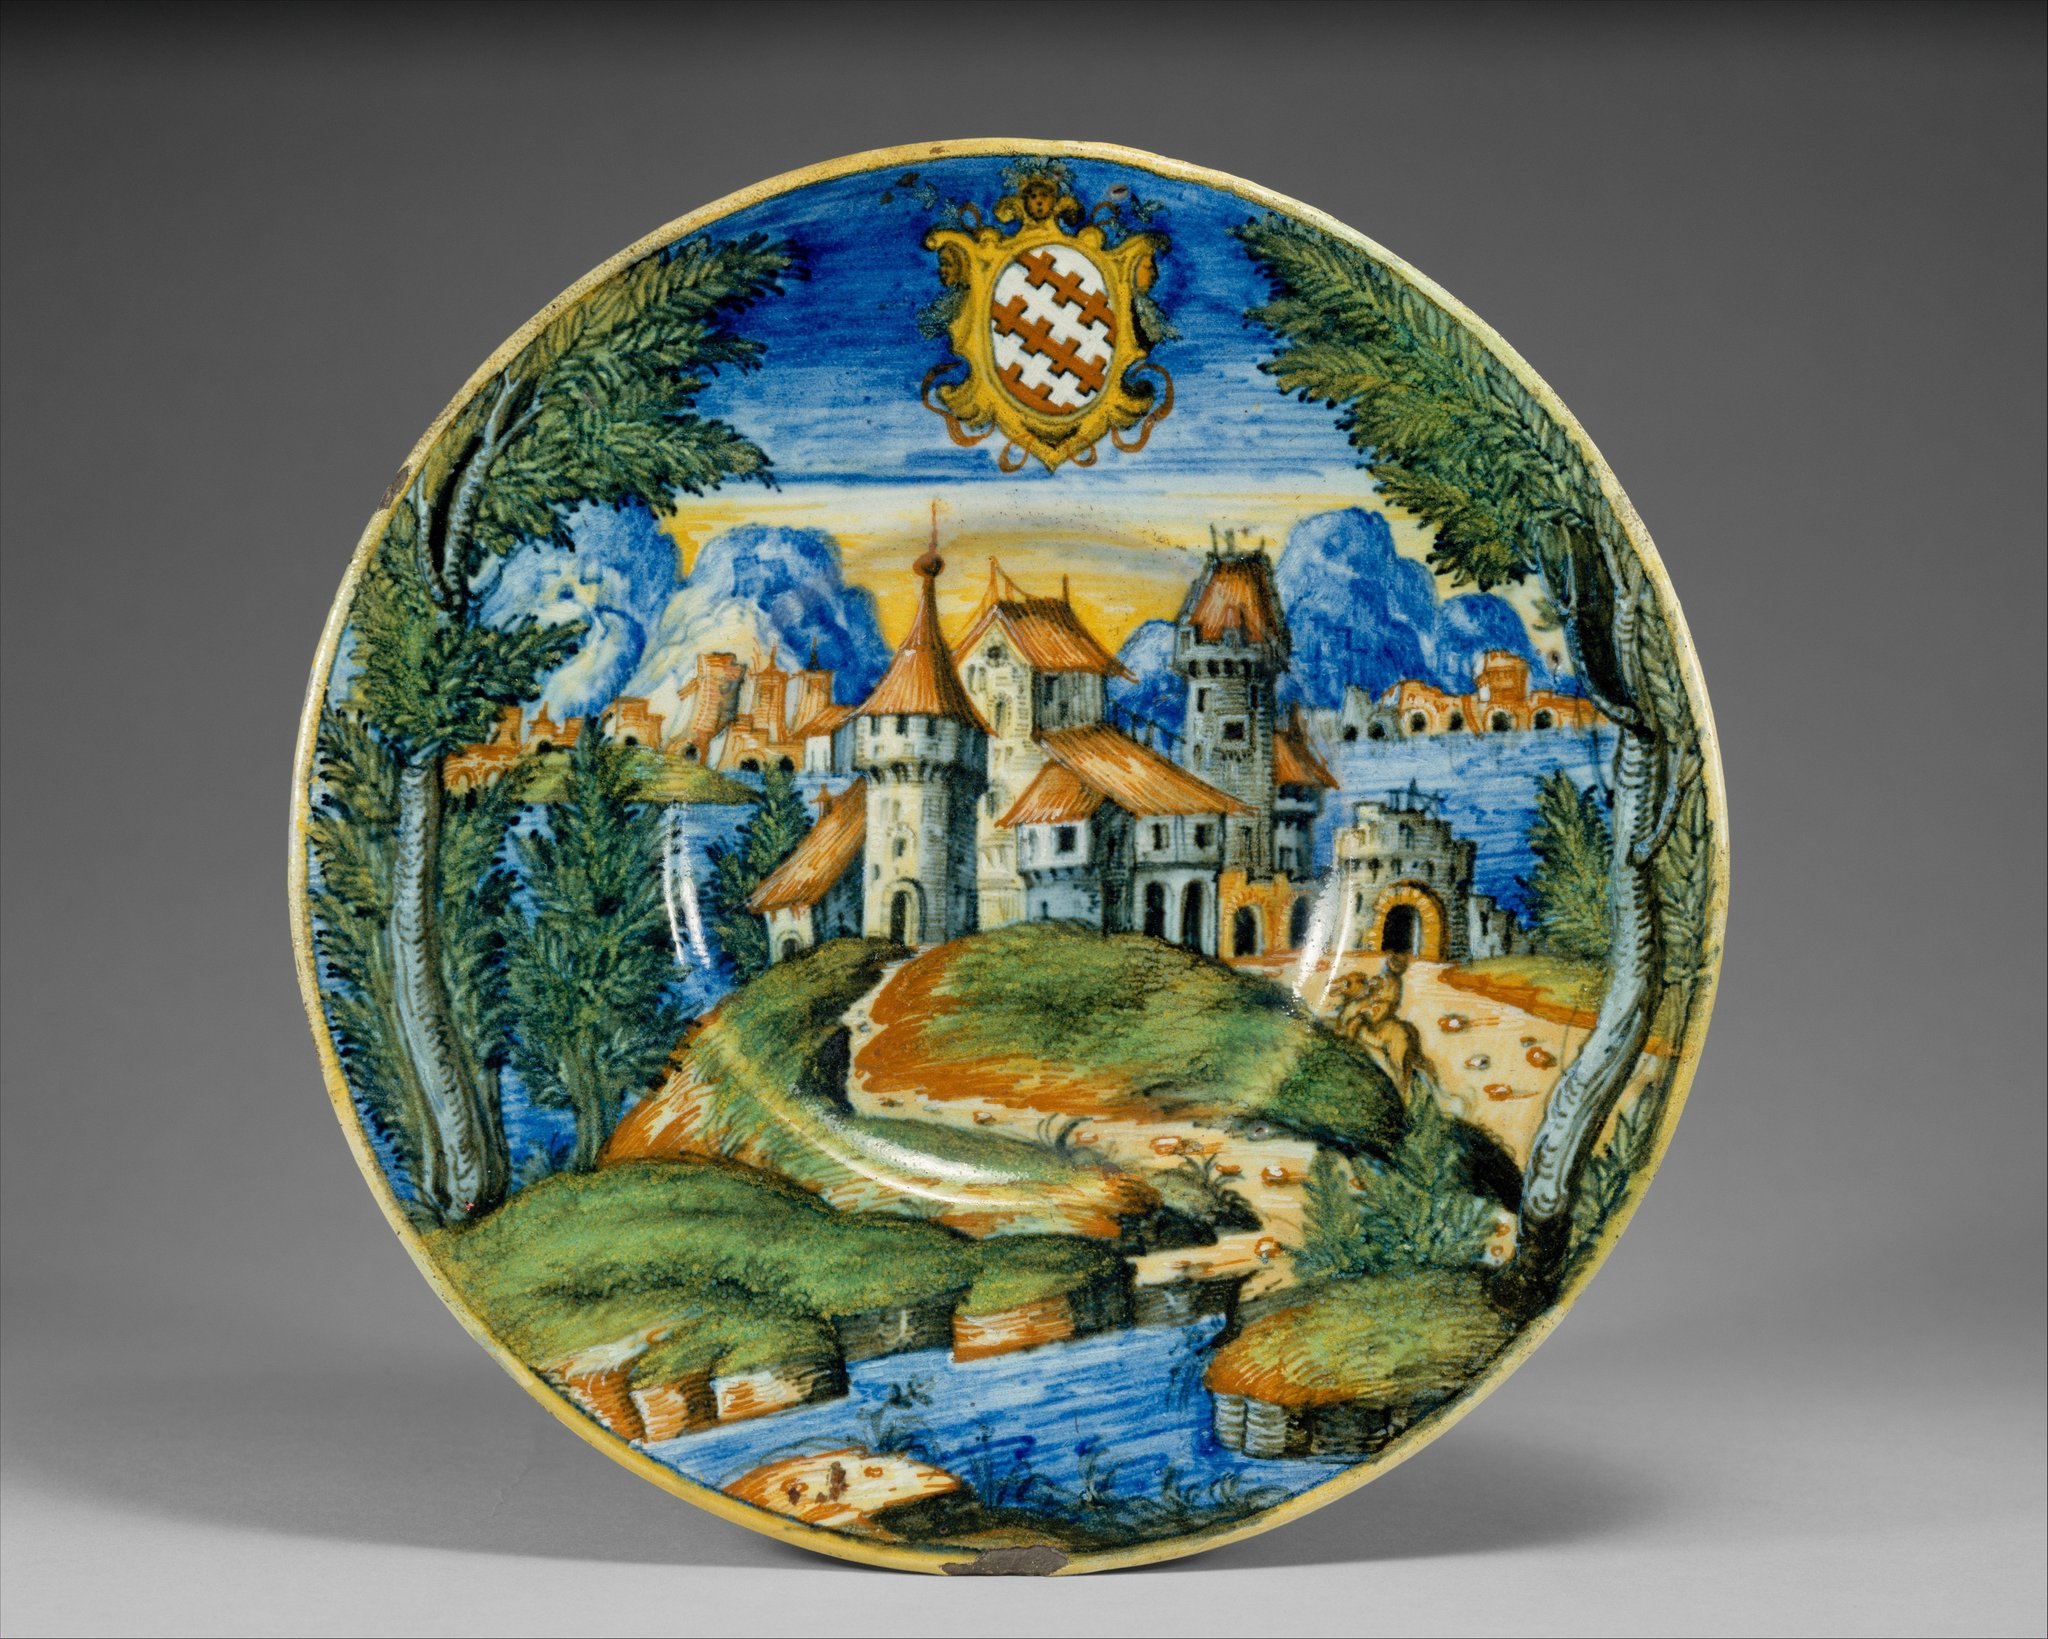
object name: plate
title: Plate (tagliere)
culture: italian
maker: workshop of guido durantino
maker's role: artist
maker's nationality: italian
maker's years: 1516-1581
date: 1550-1560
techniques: maiolica, glazing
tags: castles,landscapes,coat of arms